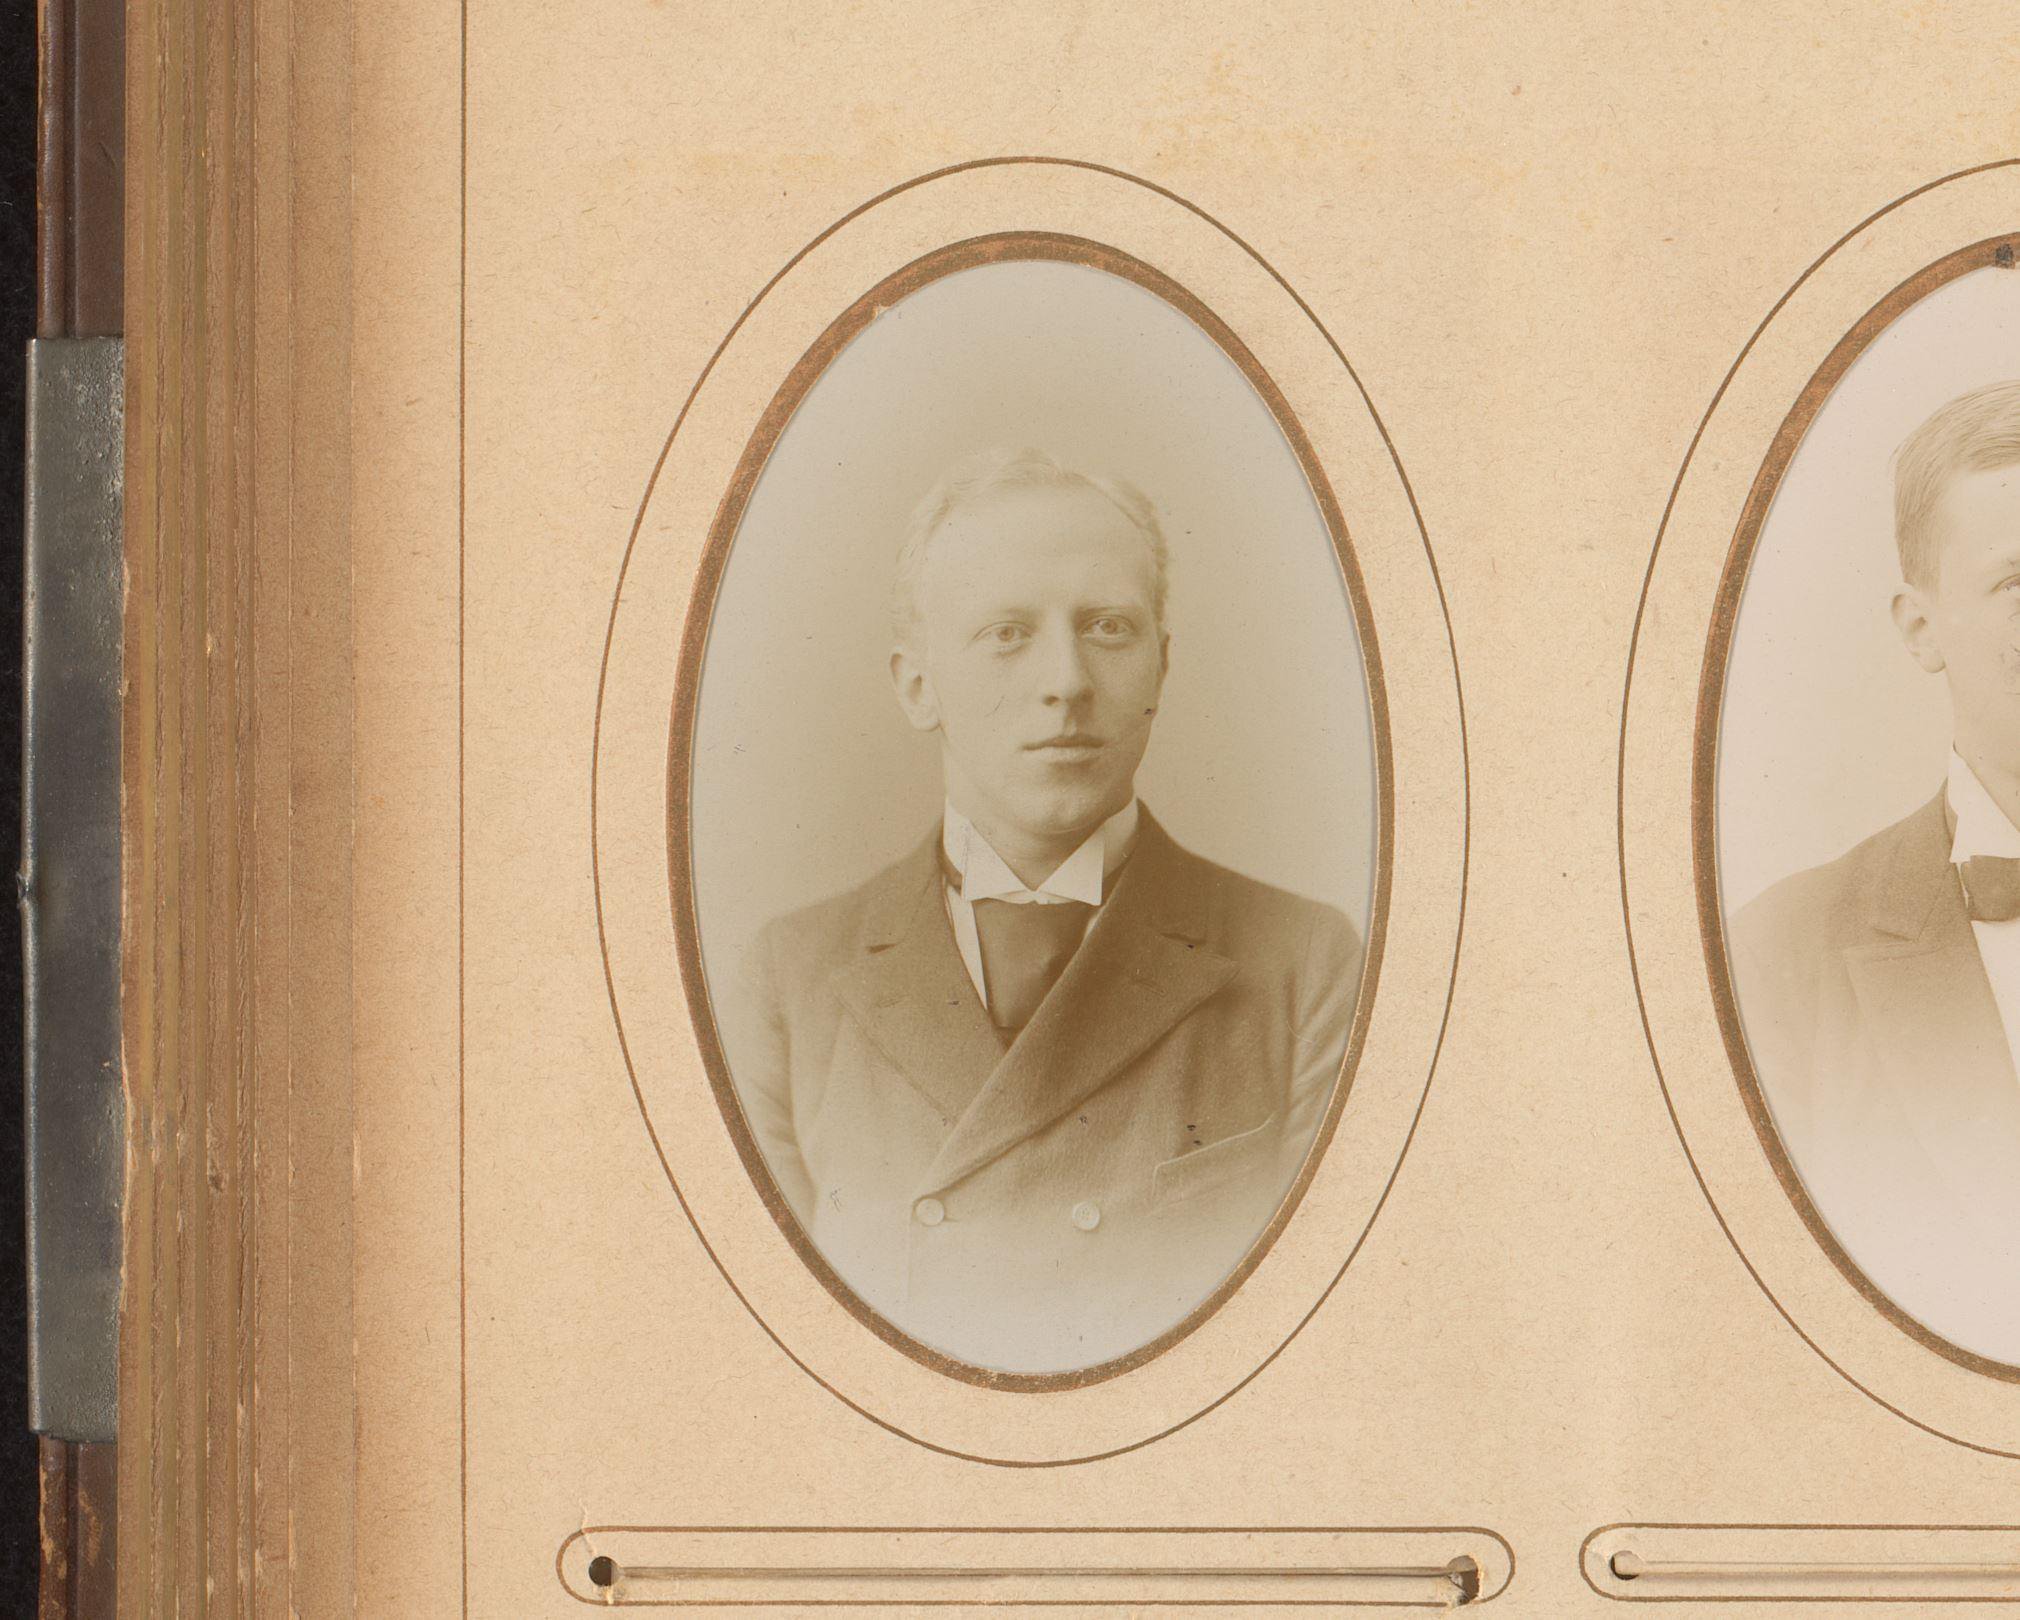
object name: carte de visite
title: Portret van een onbekende jonge man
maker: albert greiner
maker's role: fotograaf, fotostudio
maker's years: 1833-1890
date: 1880-1886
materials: paper, cardboard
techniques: collodion silver print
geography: amsterdam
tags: anonymous historical person portrayed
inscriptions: address: ‘AMSTERDAM/ NIEUWENDIJK 89.’